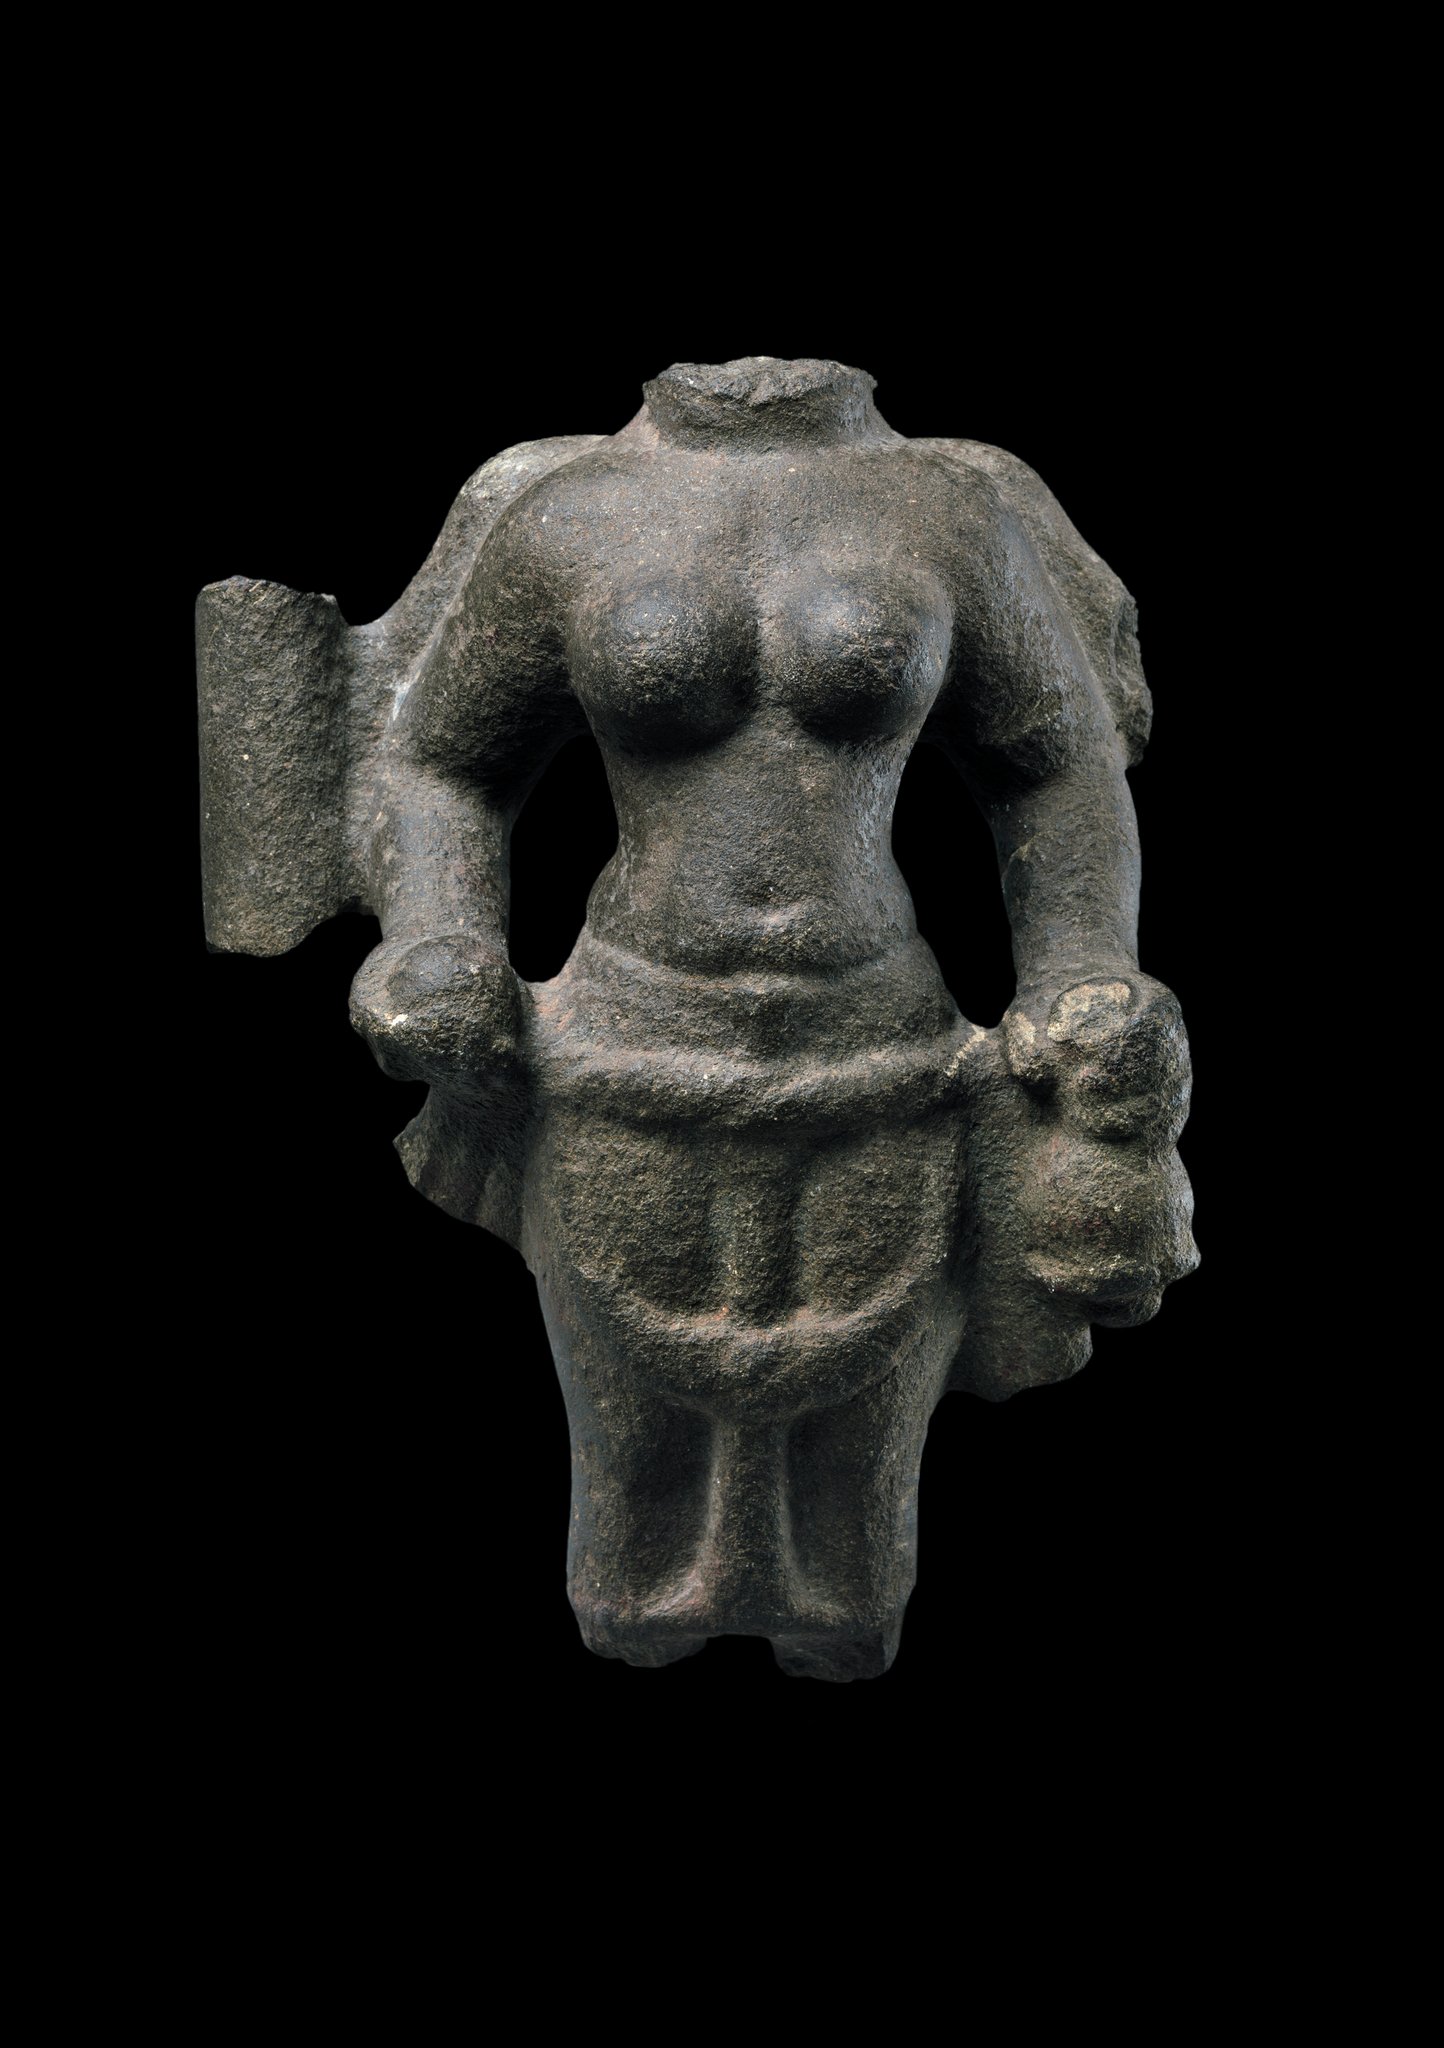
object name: figure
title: Durga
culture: southern thai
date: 467-533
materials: stone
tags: durga,hinduism